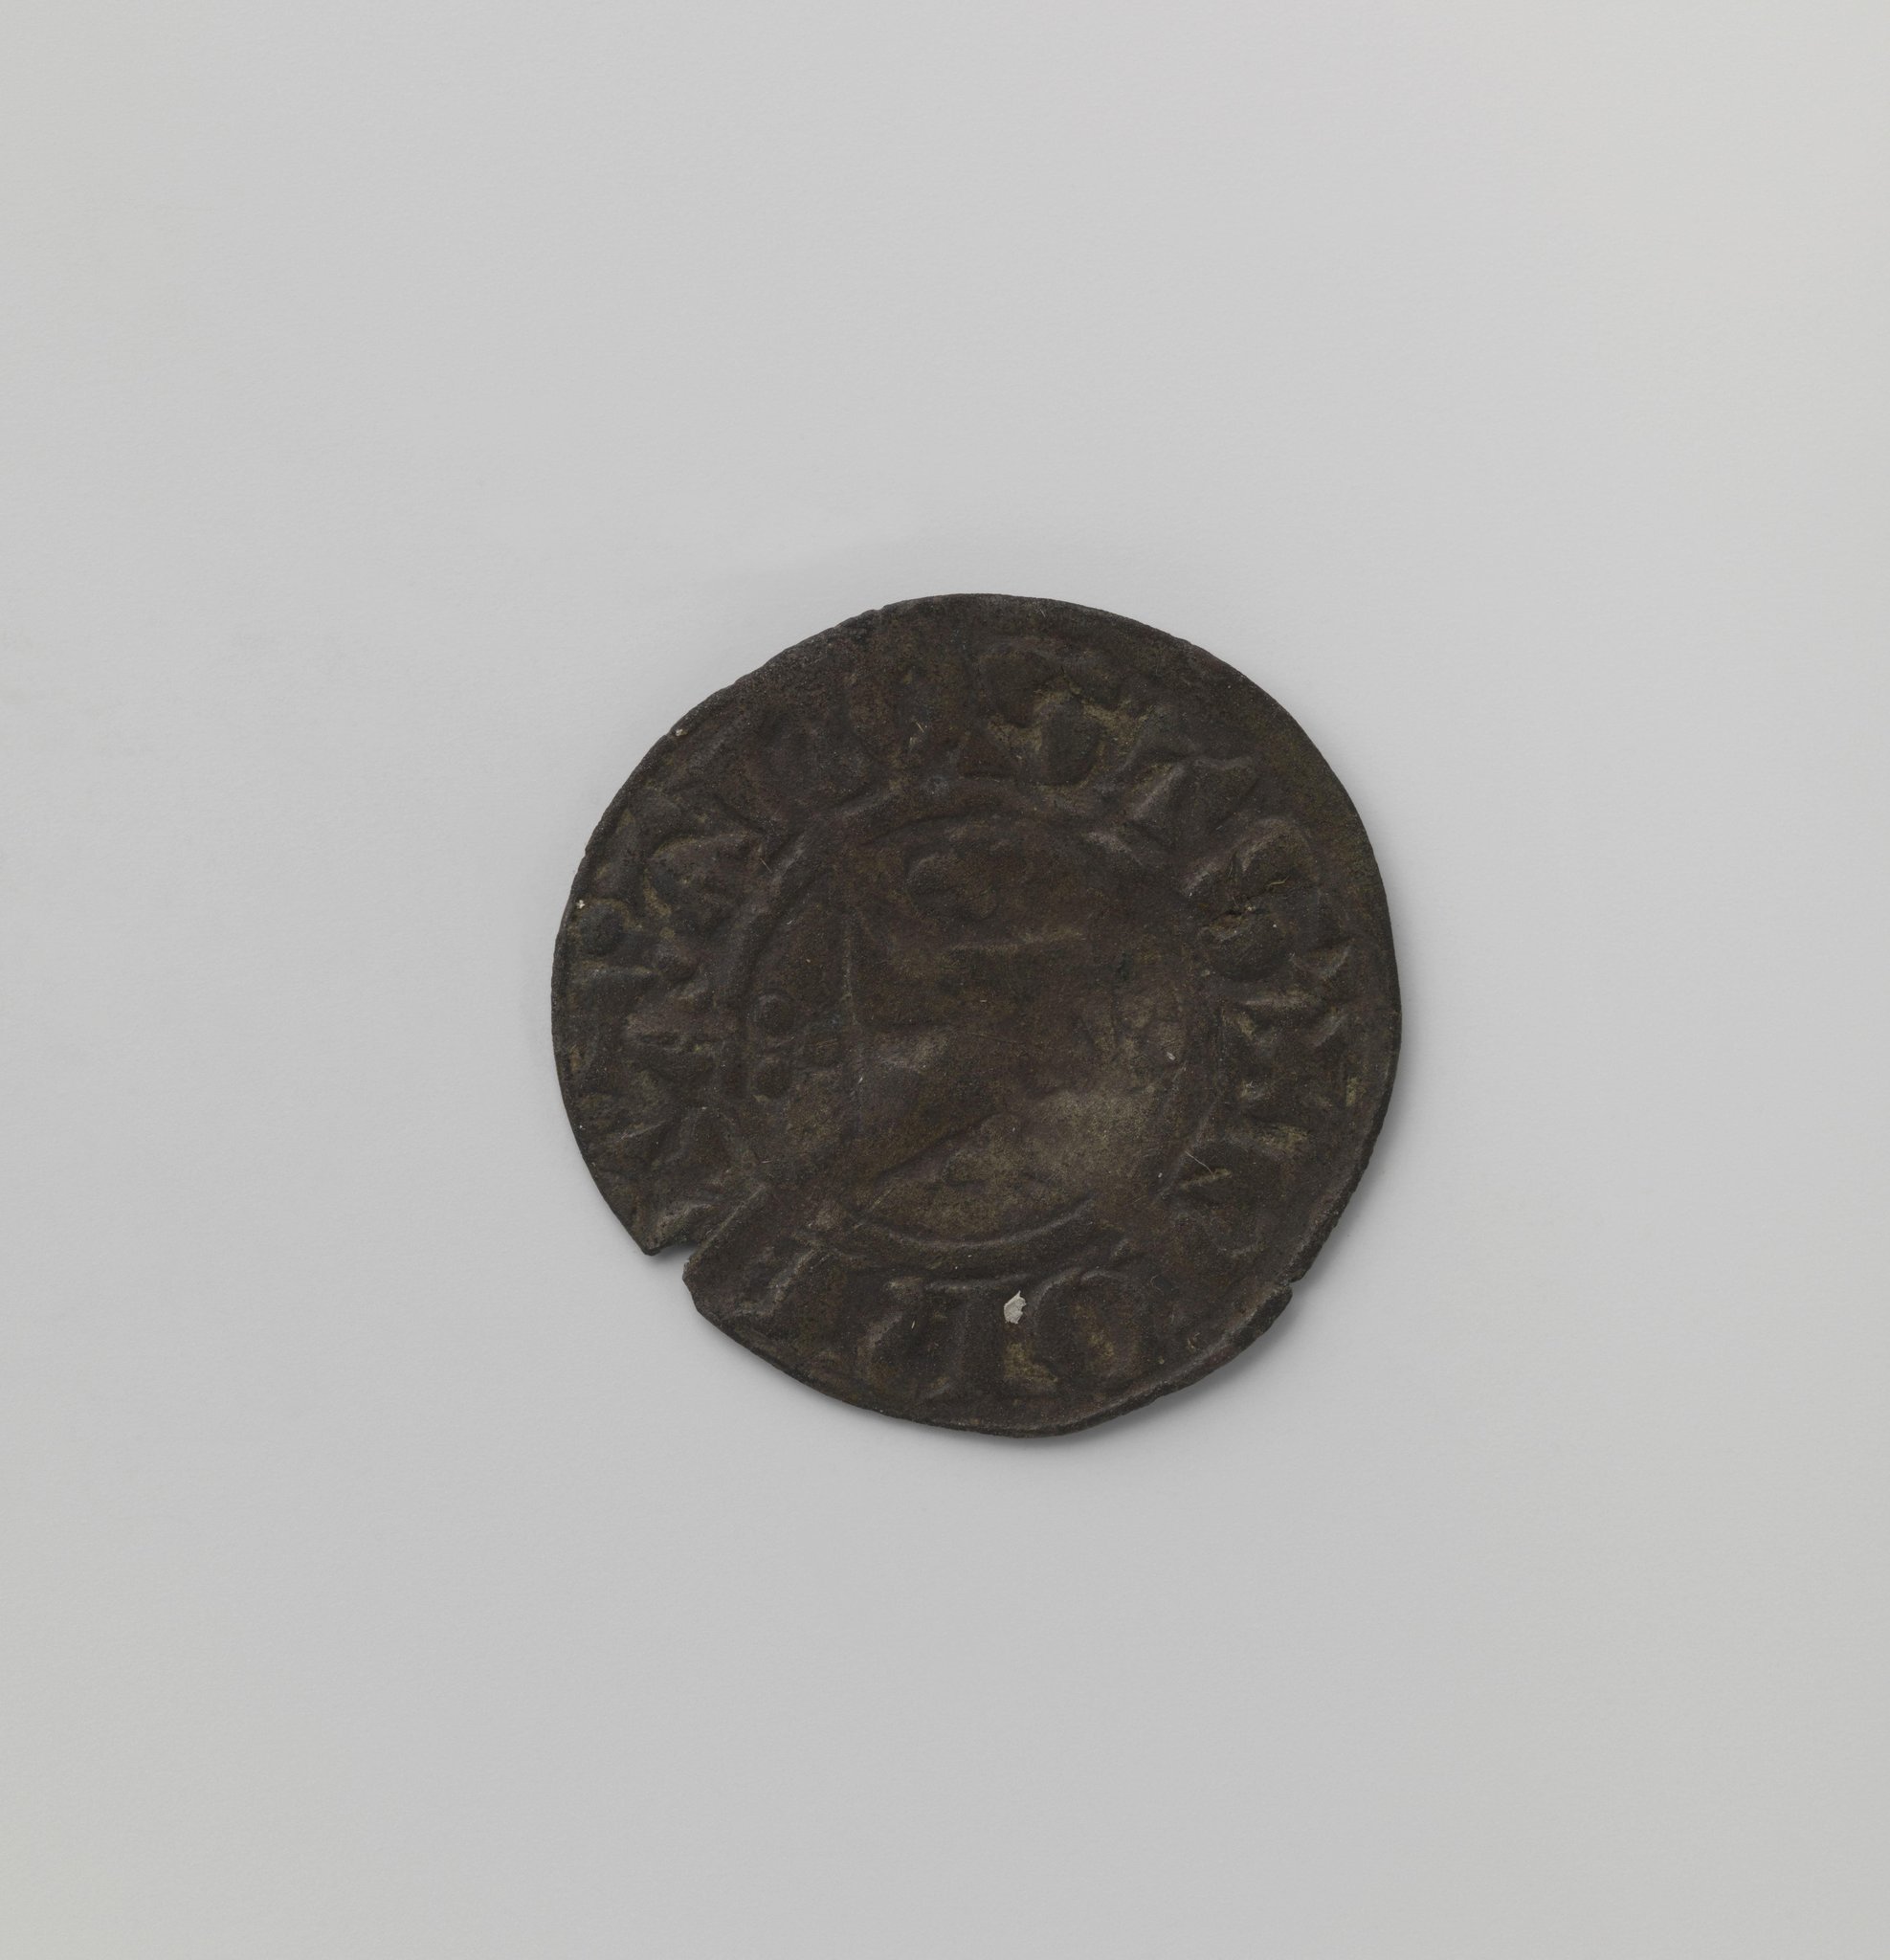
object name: coin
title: Mijt uit Vlaanderen van Lodewijk I van Crécy, 1322-1346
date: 1322-1346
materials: silver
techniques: striking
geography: aalst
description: Voorzijde: binnen versiering letter L. Keerzijde: lang gevoet kruis.